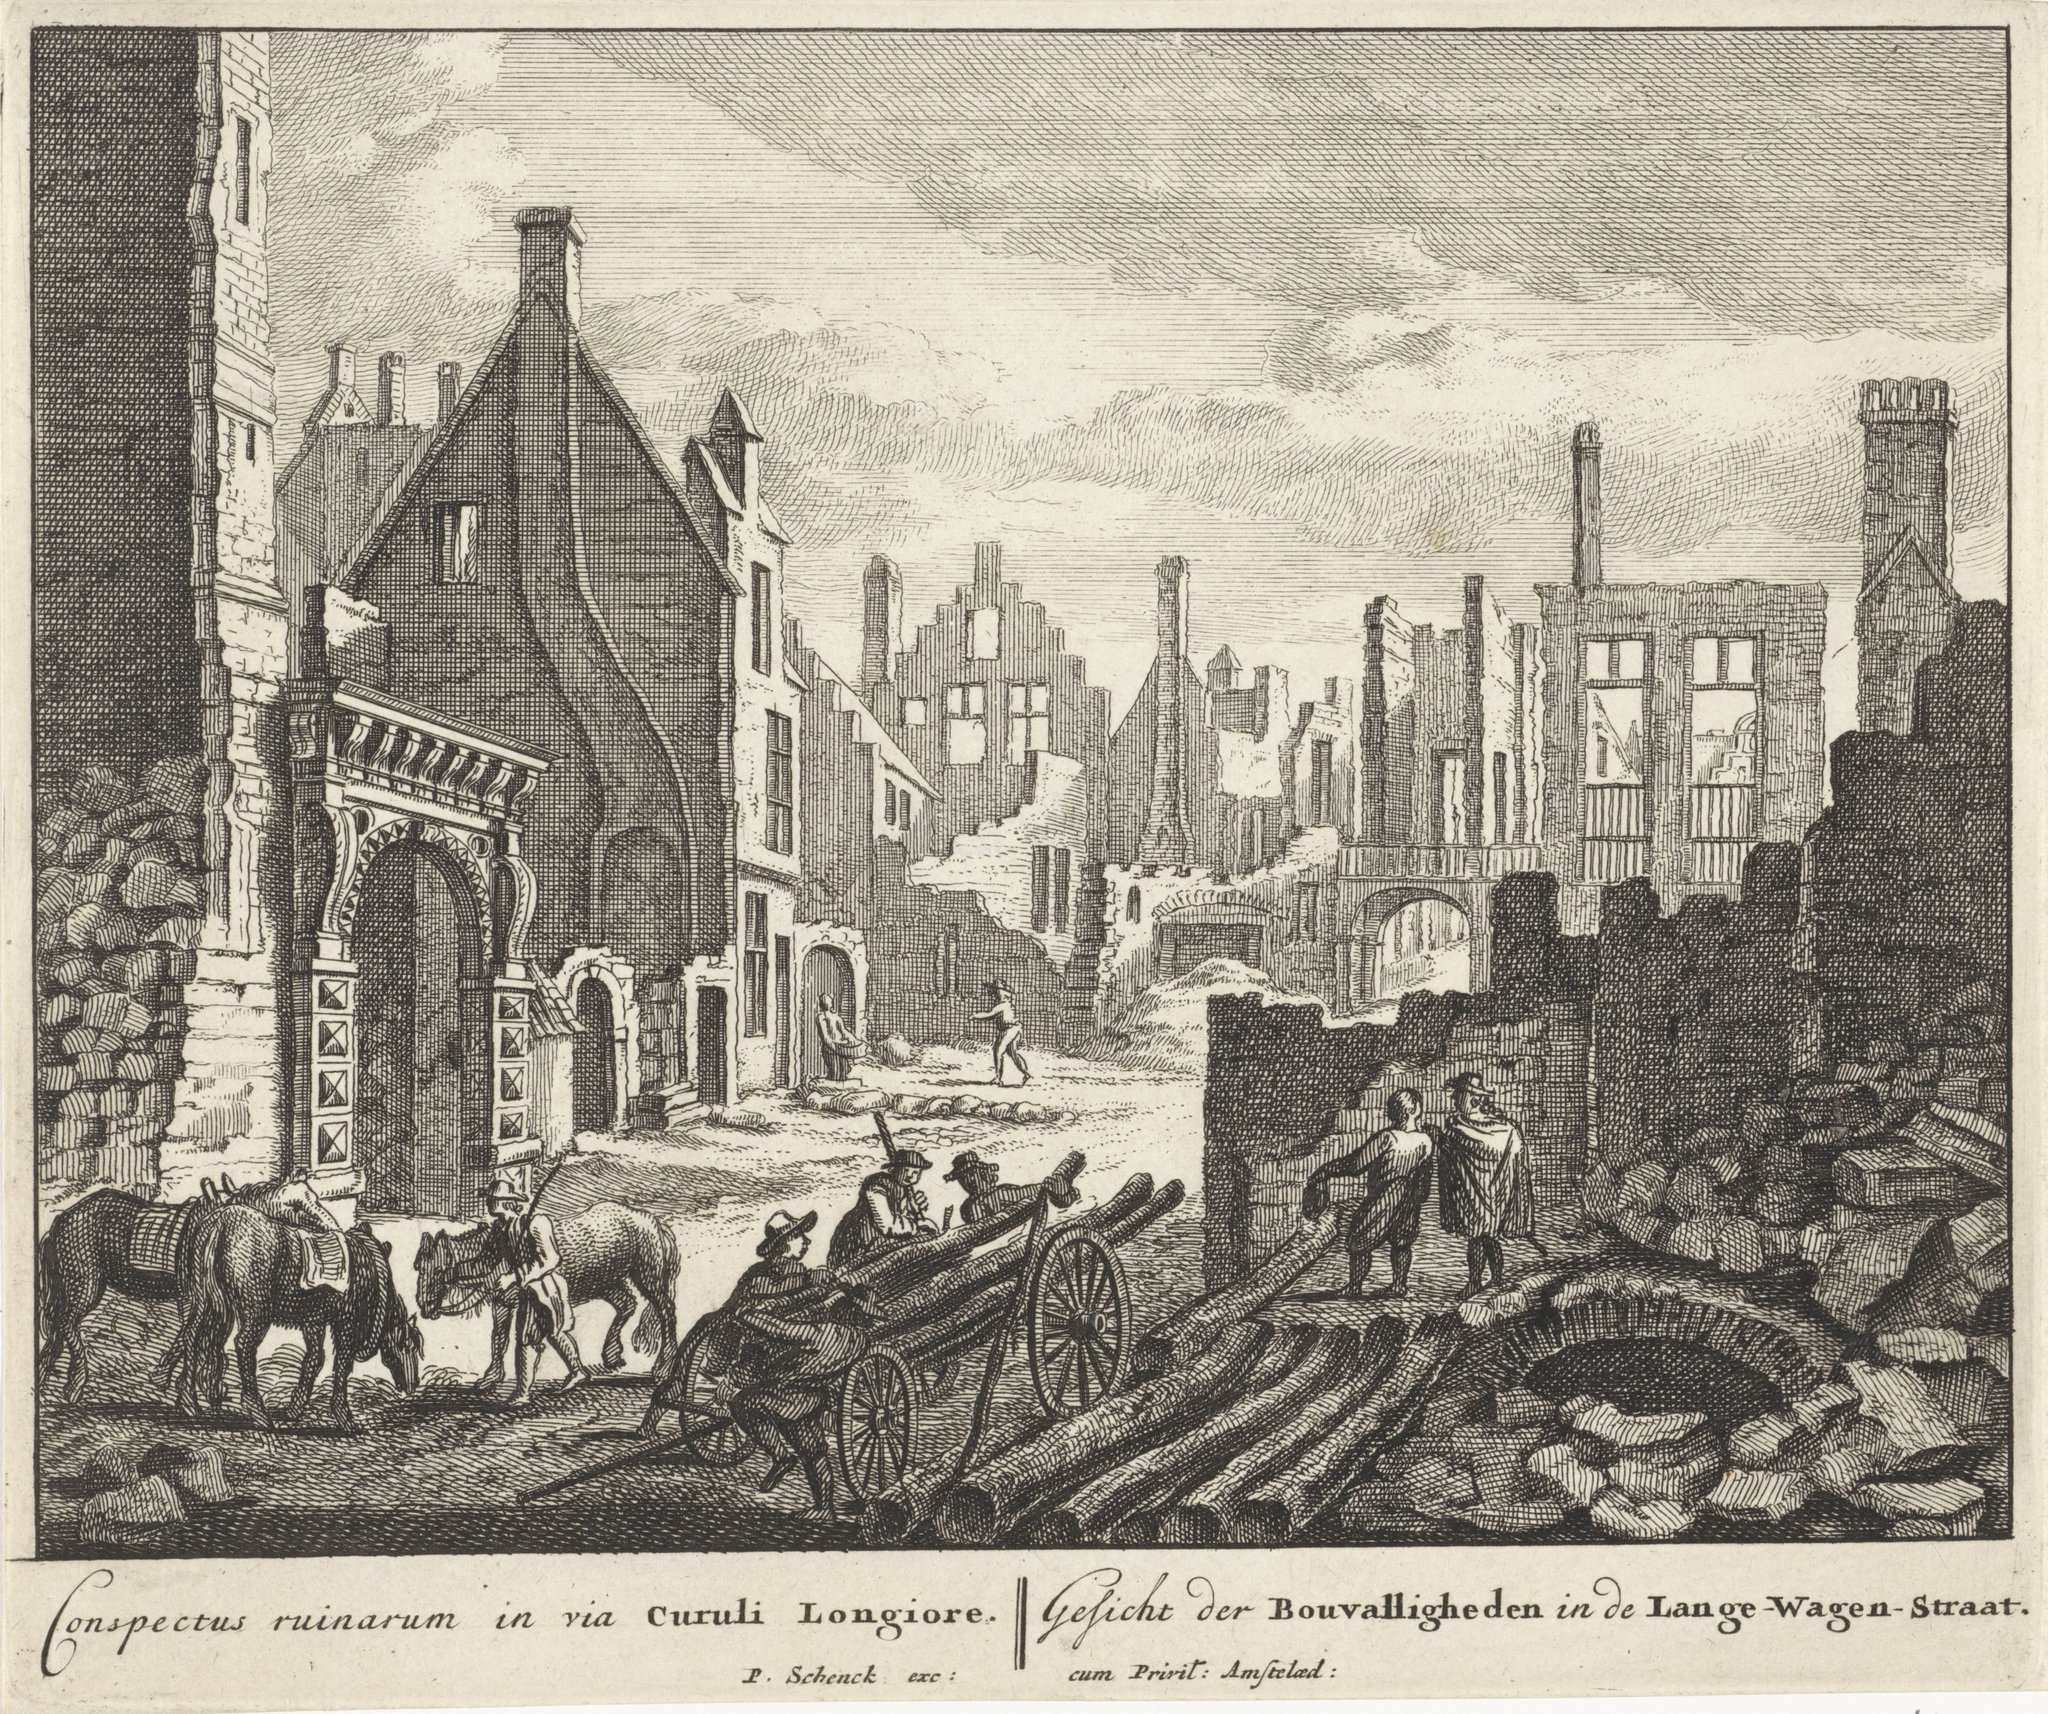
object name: print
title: Ruïnes in de Wagenstraat te Brussel, 1695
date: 1695-1711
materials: paper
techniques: etching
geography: amsterdam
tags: devastated, ruined place or city (~ warfare), brussels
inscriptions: collector's mark: Lugt 2233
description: De ruïnes in de Wagenstraat (?) te Brussel na het bombardement door de Fransen, 13-15 augustus 1695.